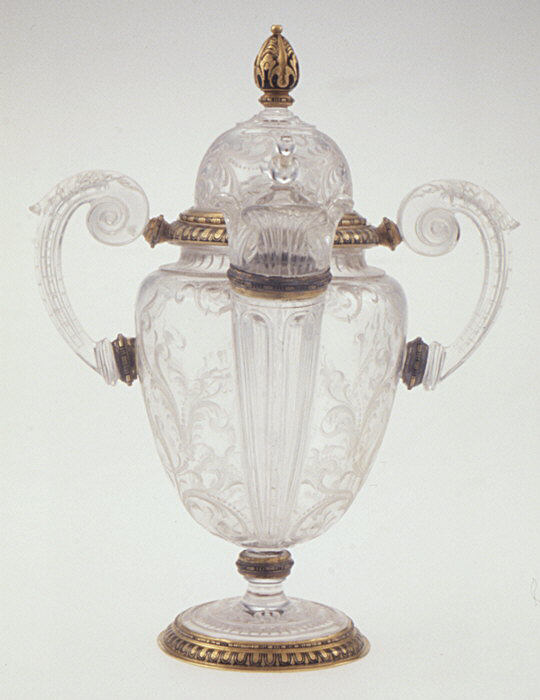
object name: vase with cover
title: Double-spouted vase with cover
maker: reinhold vasters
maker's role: artist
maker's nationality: german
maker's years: 1827-1909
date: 1870-1890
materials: gold, quartz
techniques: enamel